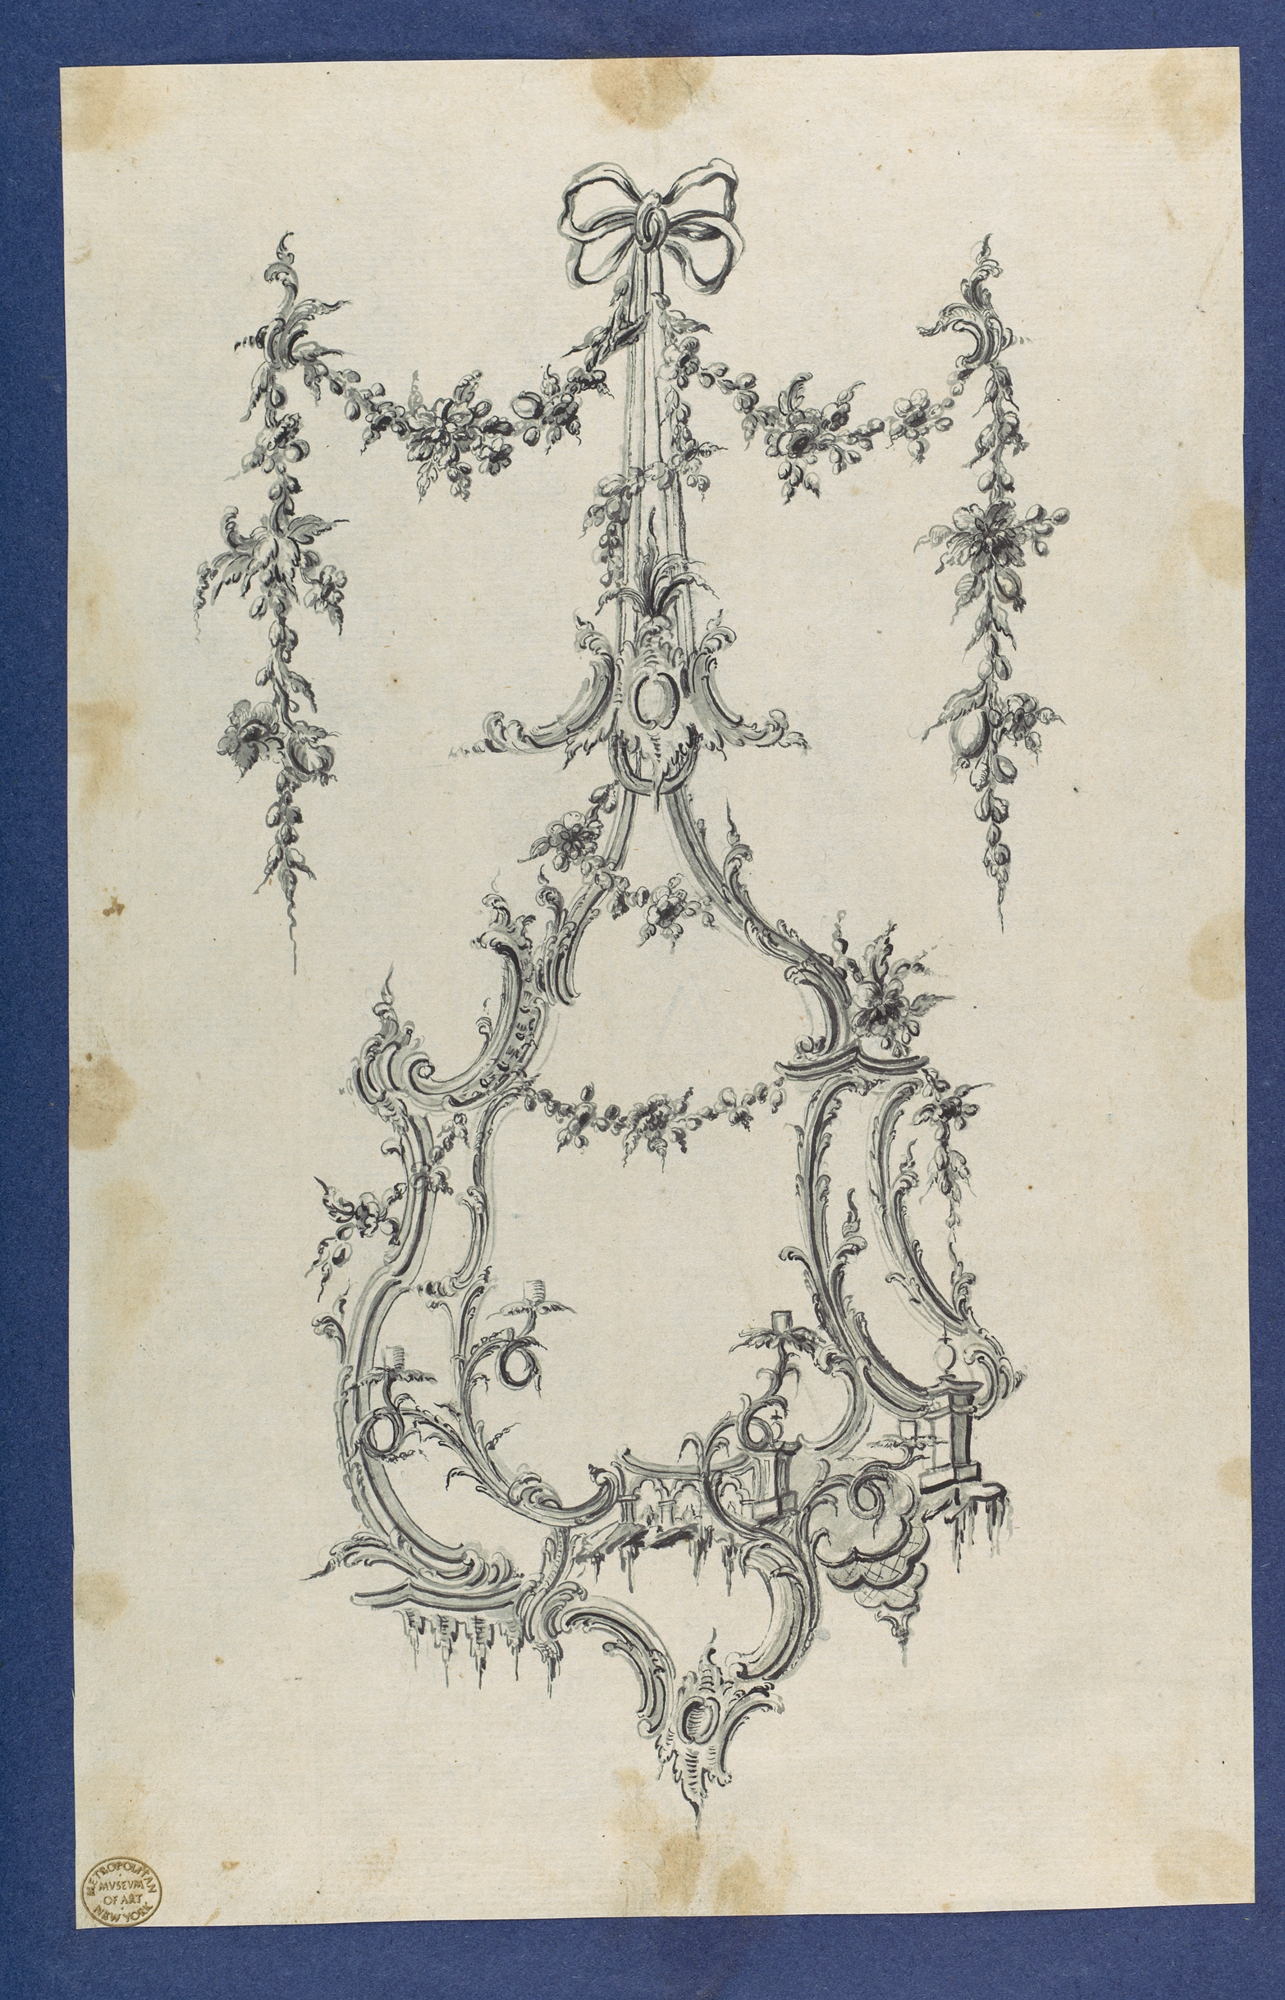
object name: drawing ornament architecture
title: Mirror with Sconces, in Chippendale Drawings, Vol. I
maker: thomas chippendale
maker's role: artist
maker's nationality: british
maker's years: 1718-1779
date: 1753-1762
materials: ink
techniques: wash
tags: flowers,mirrors